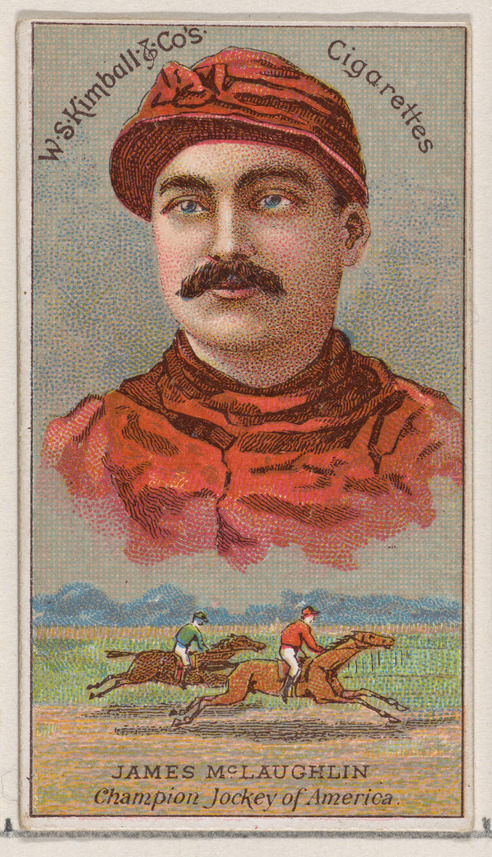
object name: print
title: James McLaughlin, Champion Jockey of America, from the Champions of Games and Sports series (N184, Type 1) issued by W.S. Kimball & Co.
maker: w.s. kimball & co.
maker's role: publisher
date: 1887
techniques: color lithograph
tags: men,athletes,jockeys